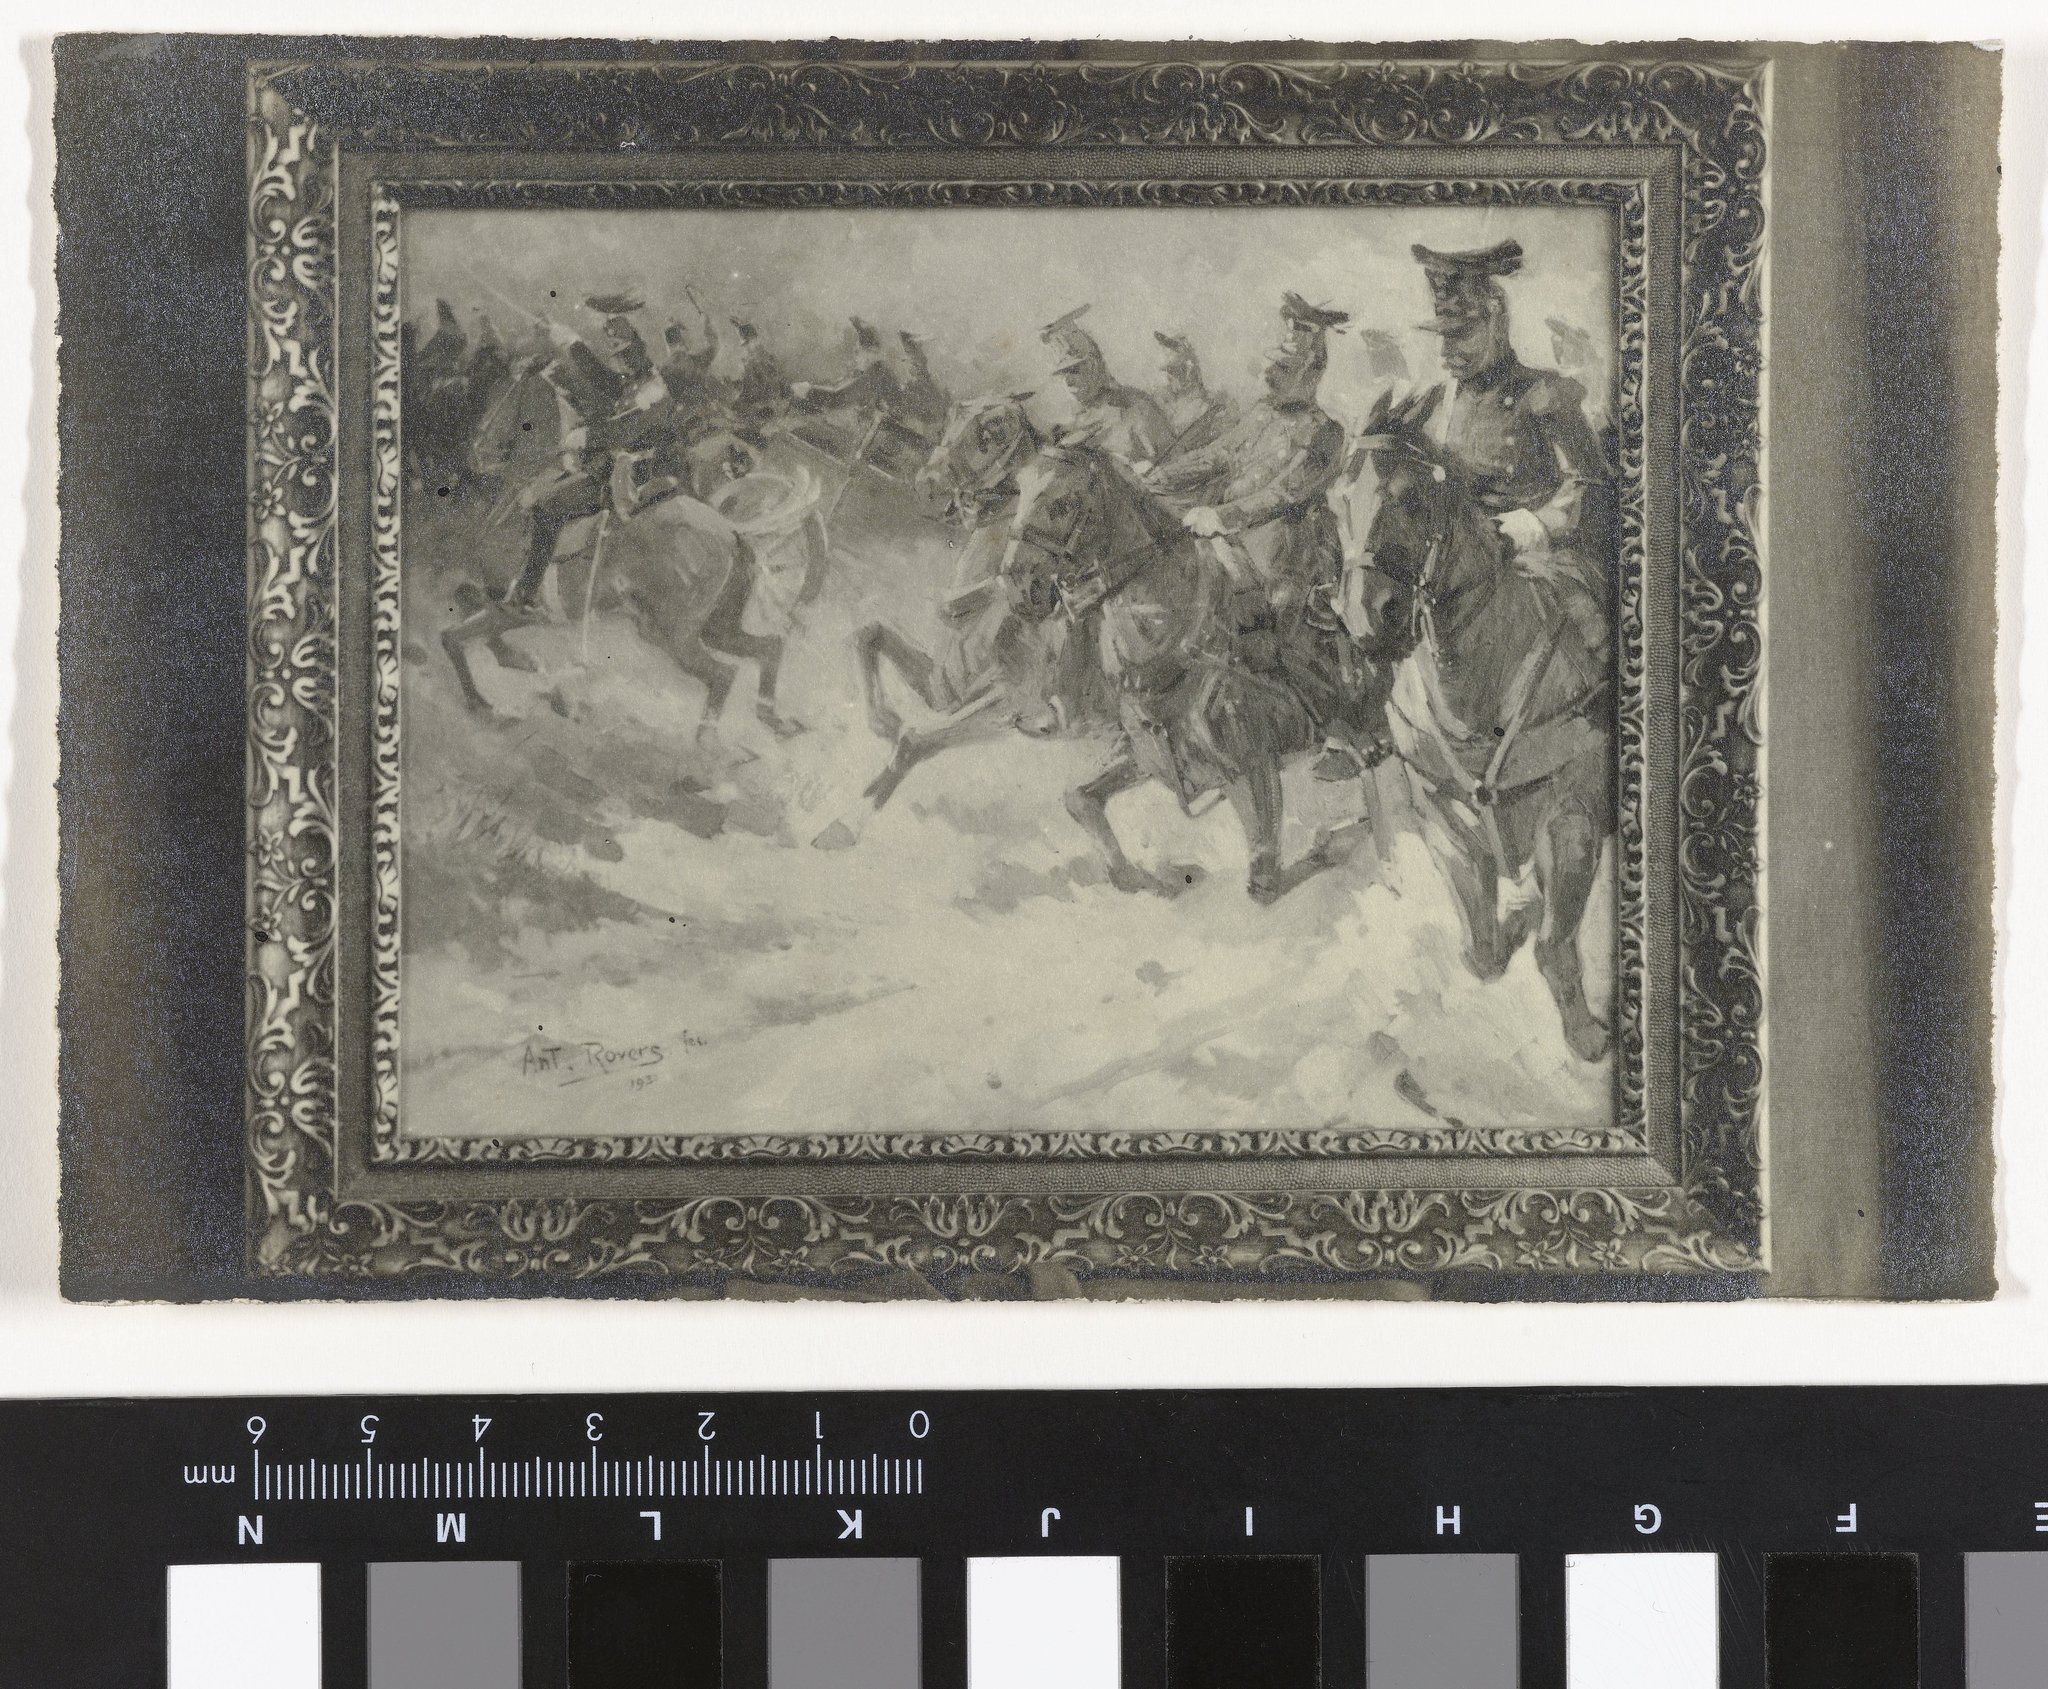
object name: reproduction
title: Fotoreproductie van een schilderij van een rijdende cavalerie door vermoedelijk Anton Rovers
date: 1931-1950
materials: photographic support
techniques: gelatin silver print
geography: netherlands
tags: picture, painting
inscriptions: name: ‘Vosmaer’